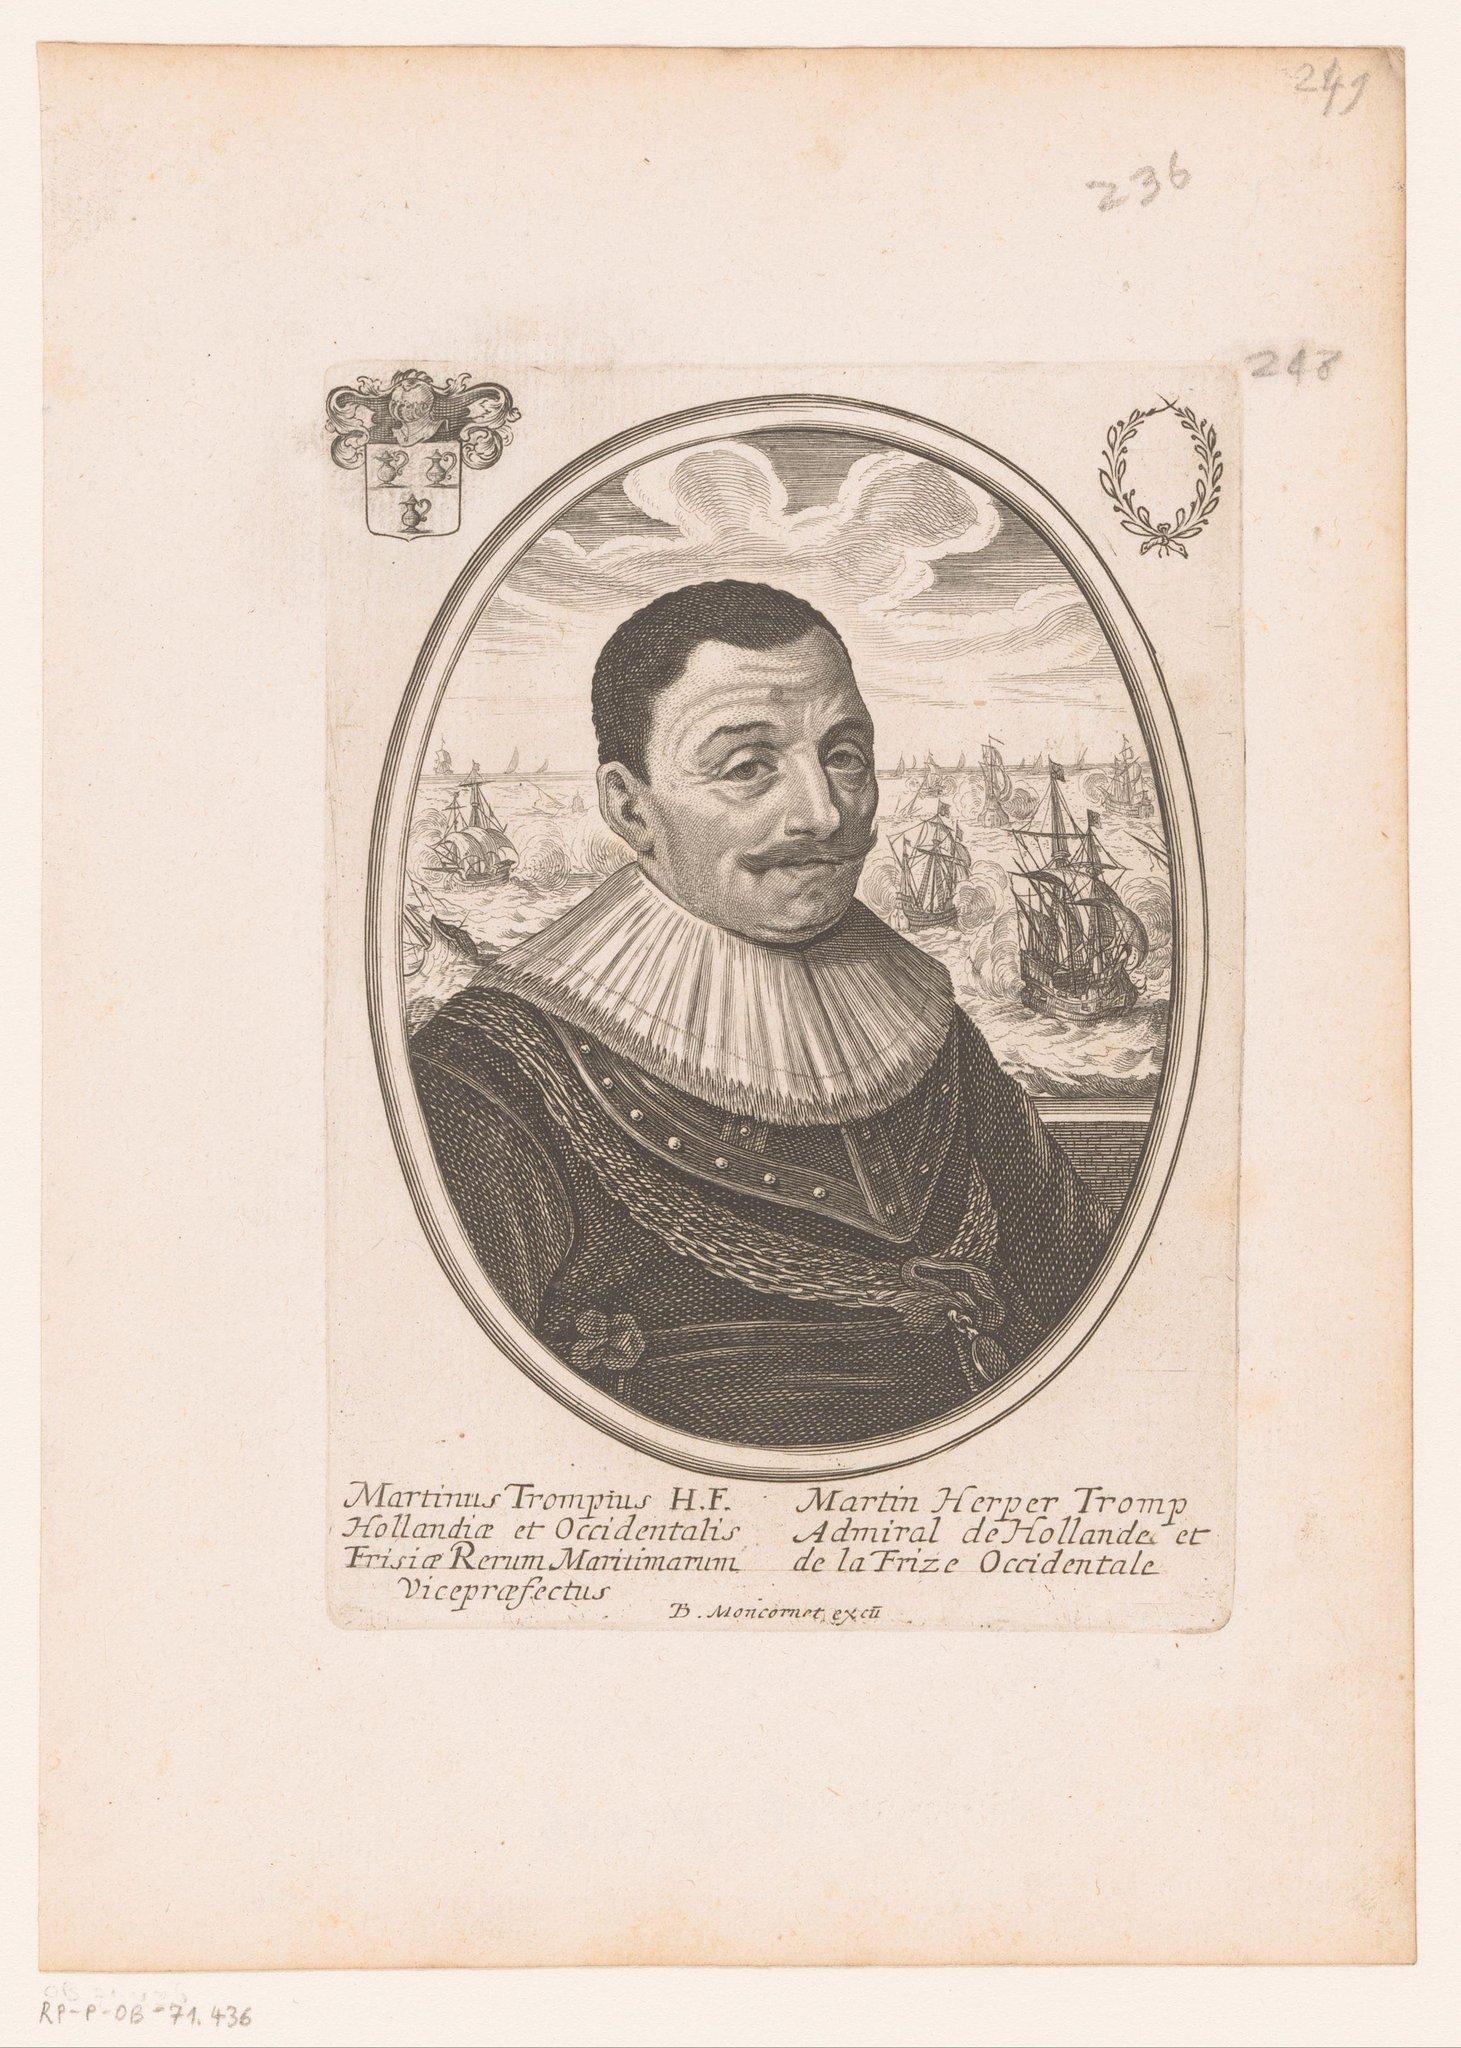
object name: print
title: Portret van Maarten Harpertszoon Tromp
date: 1638-1668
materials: paper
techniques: engraving, etching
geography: paris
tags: maarten harpertszoon tromp, historical persons, ranks in the navy